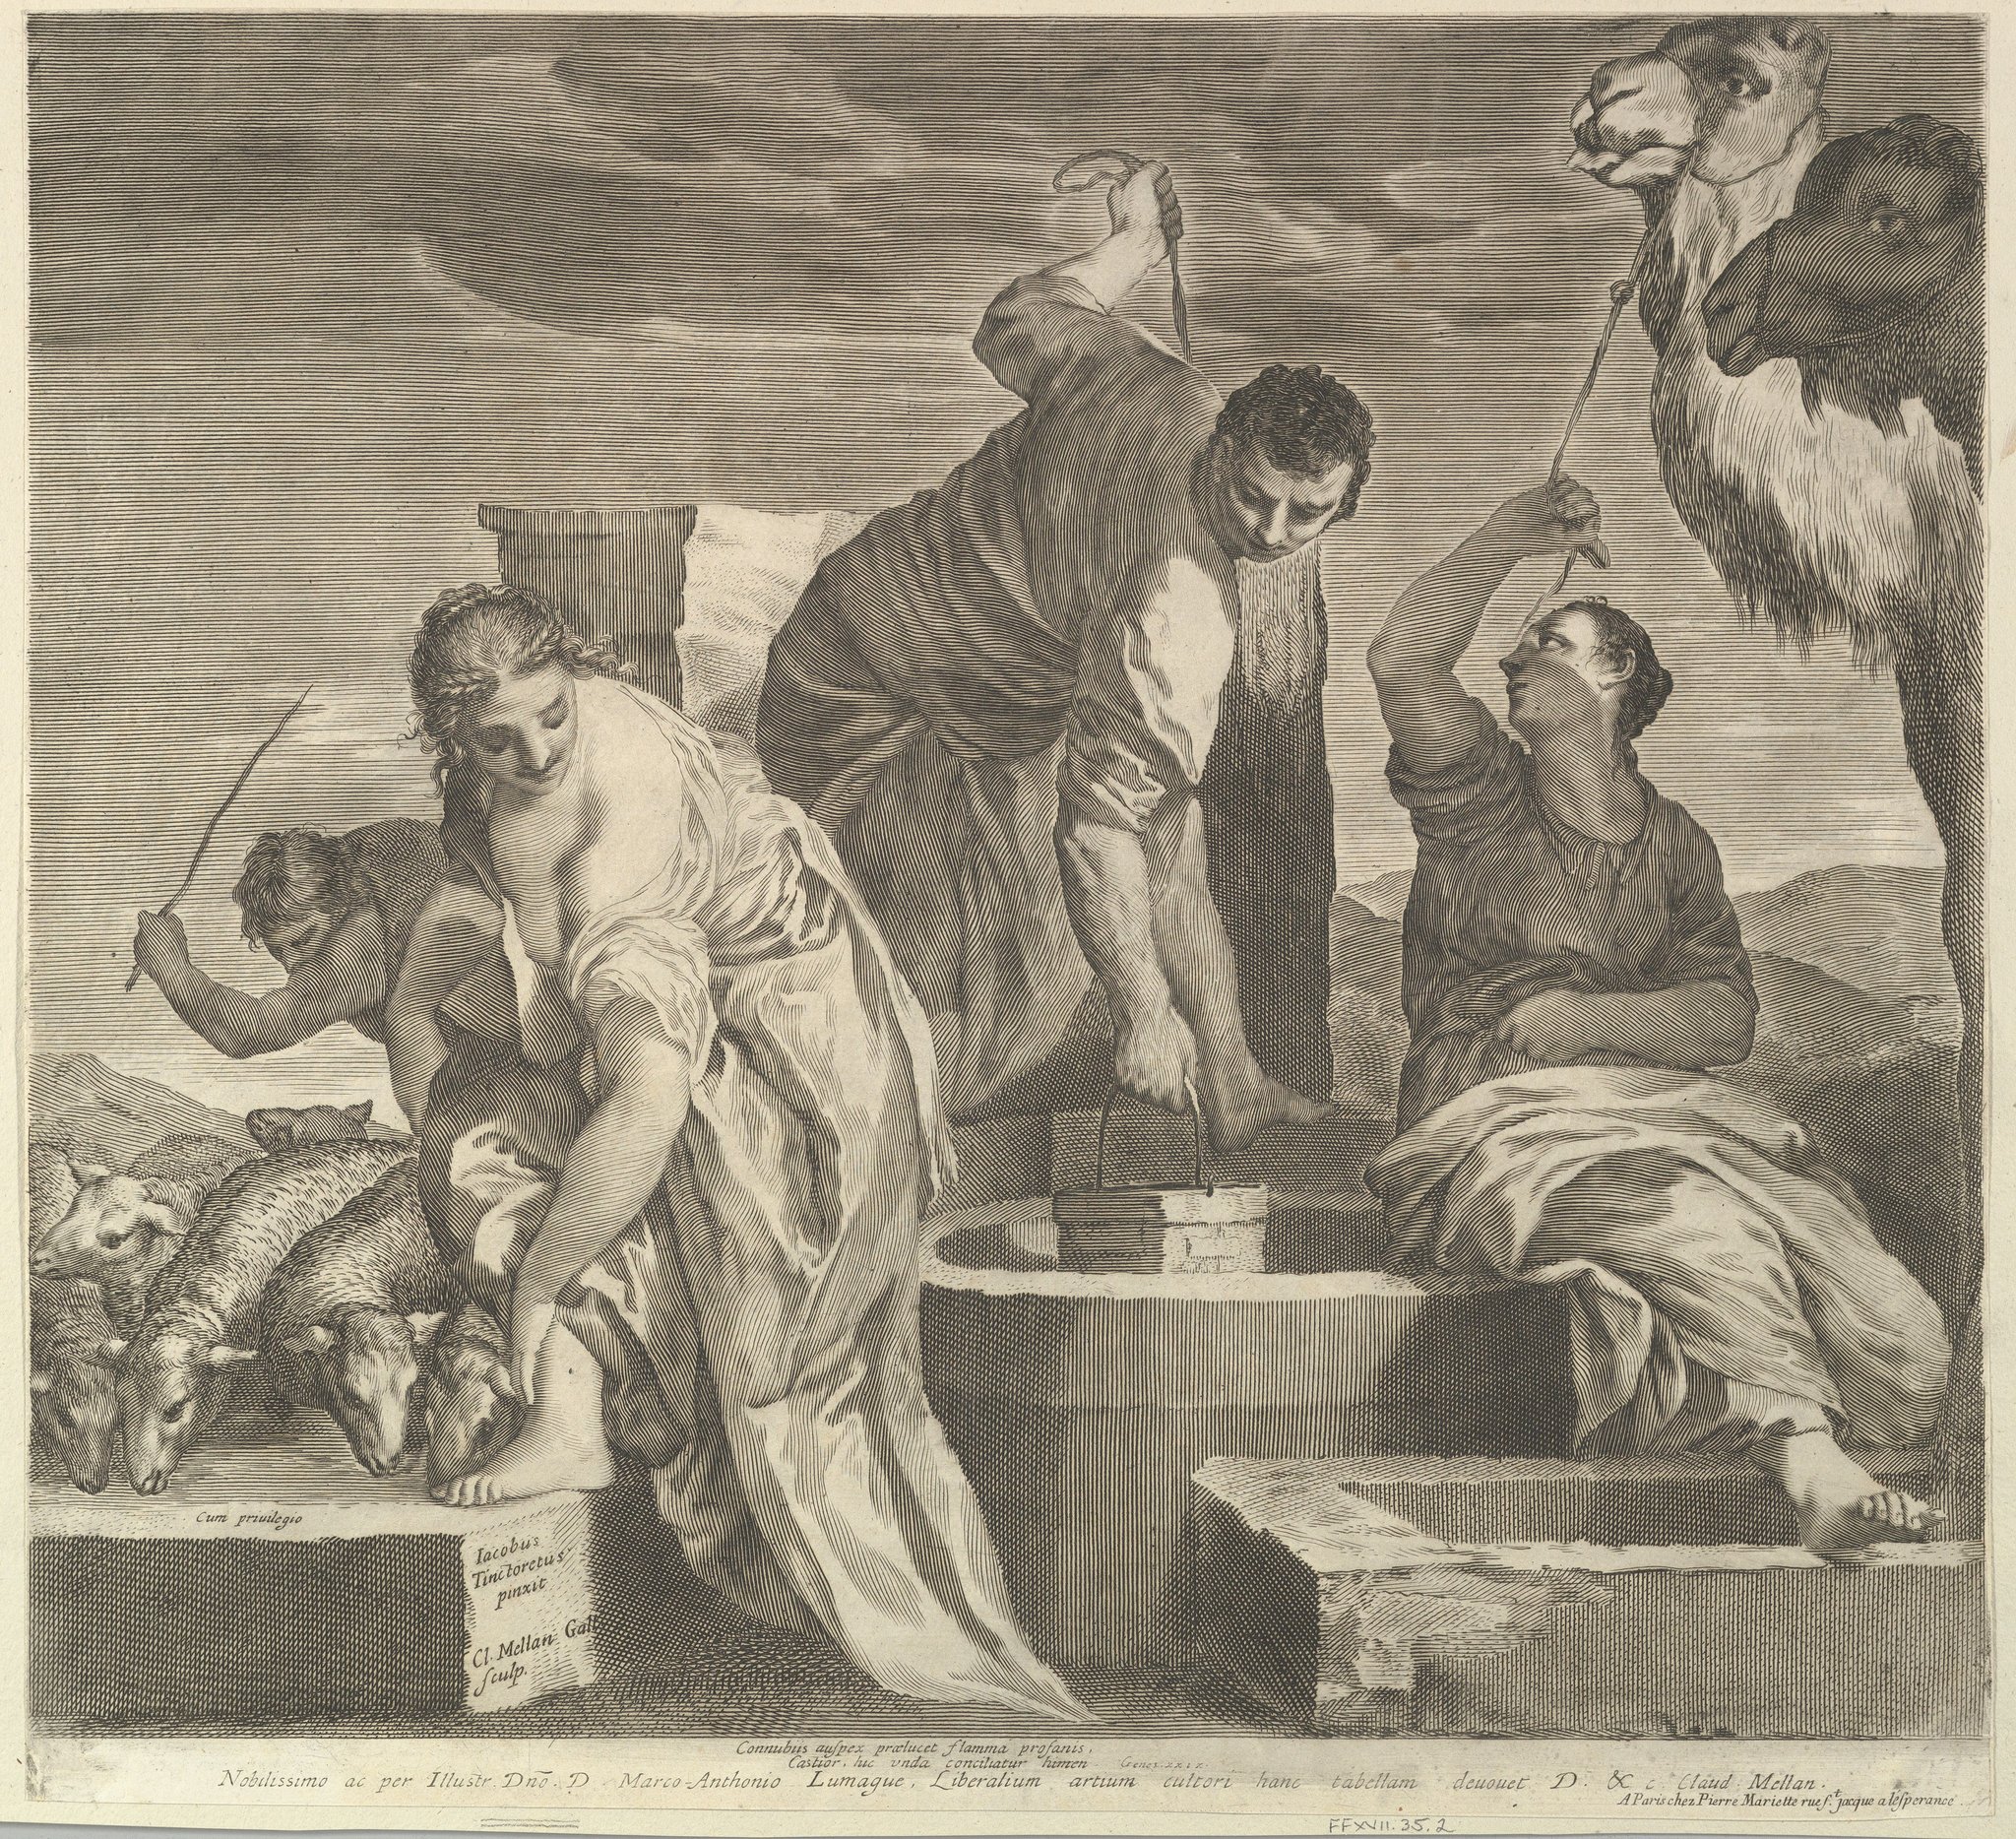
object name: print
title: Jacob Draws Water for Rachel's Animals (Jacob abreuve le troupeau de Rachel)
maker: claude mellan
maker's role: artist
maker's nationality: french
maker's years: 1598-1688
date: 1600-1688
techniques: engraving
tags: wells,men,women,camels,sheep